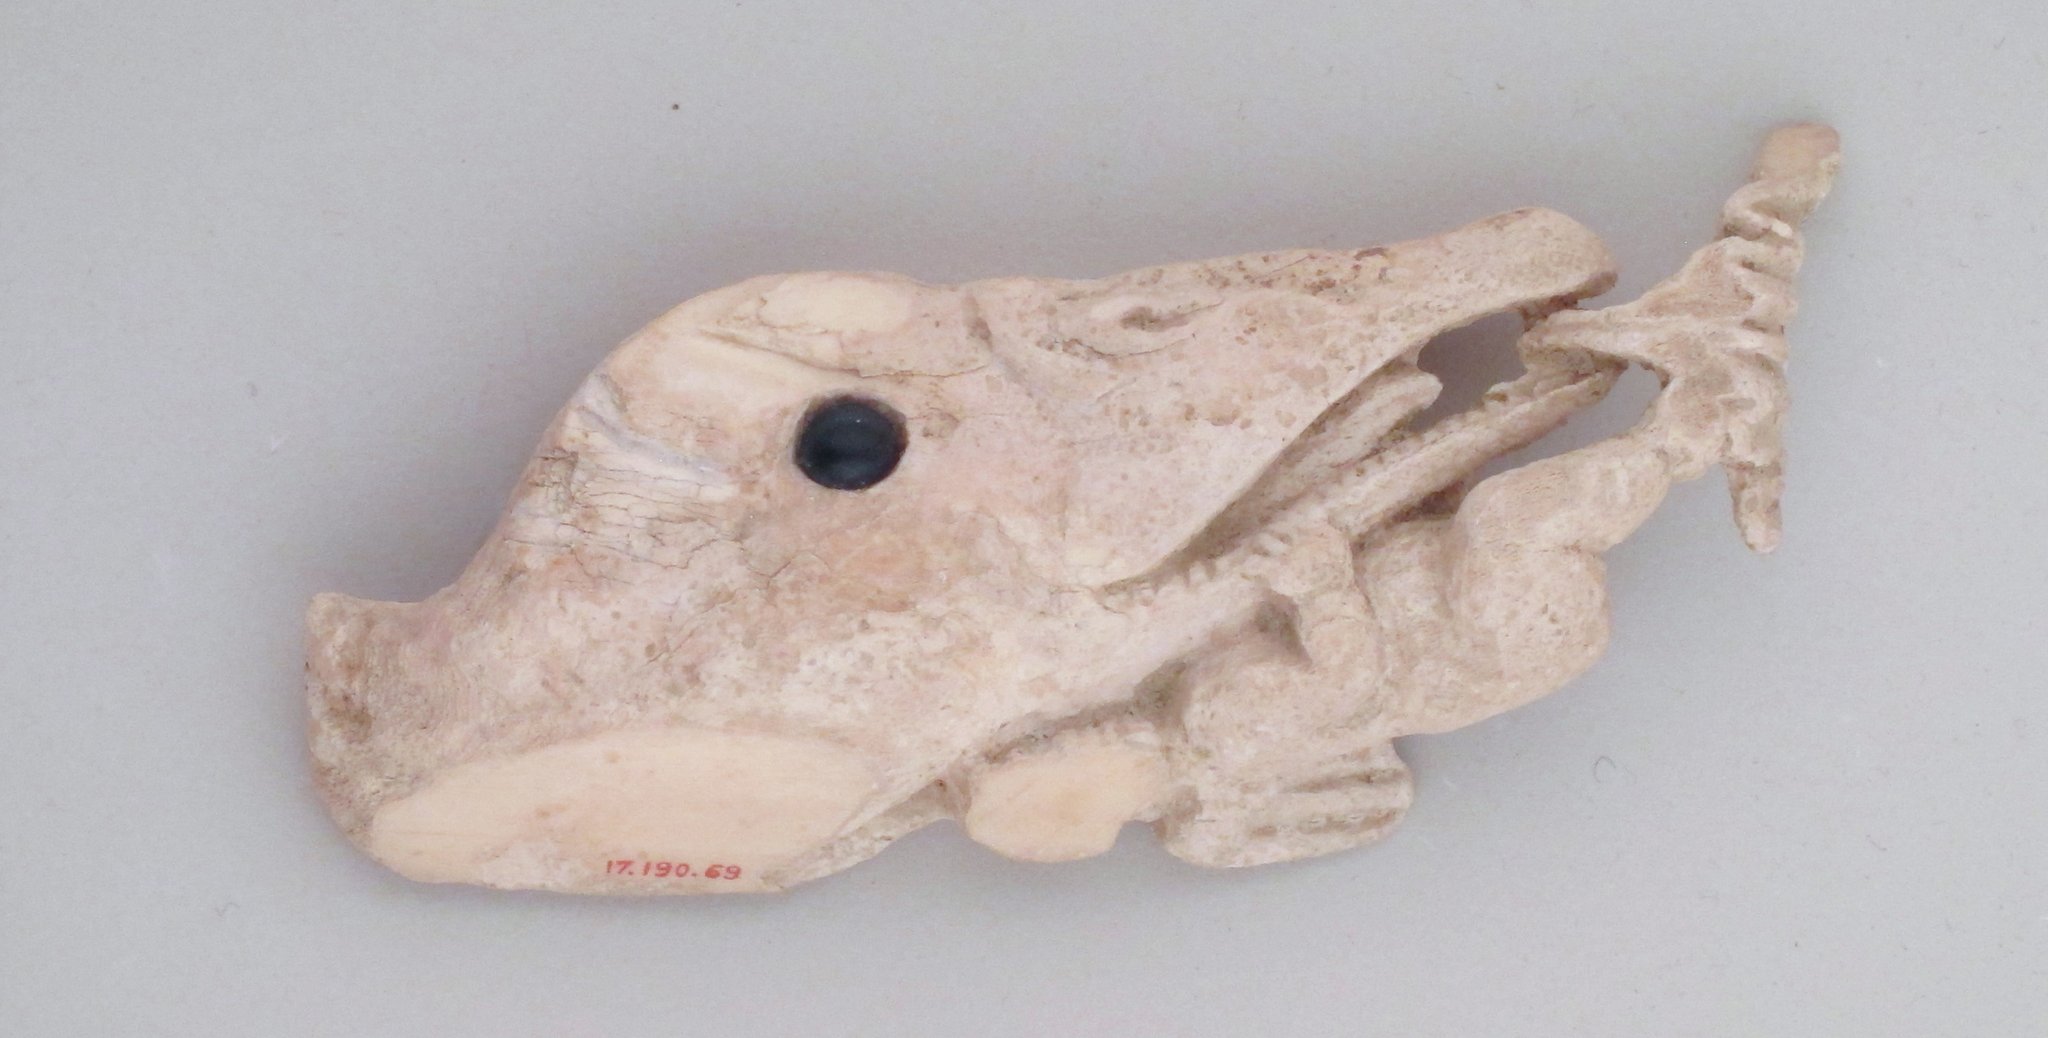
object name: relief from couch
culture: roman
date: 1-100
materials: ivory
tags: ducks,cupid